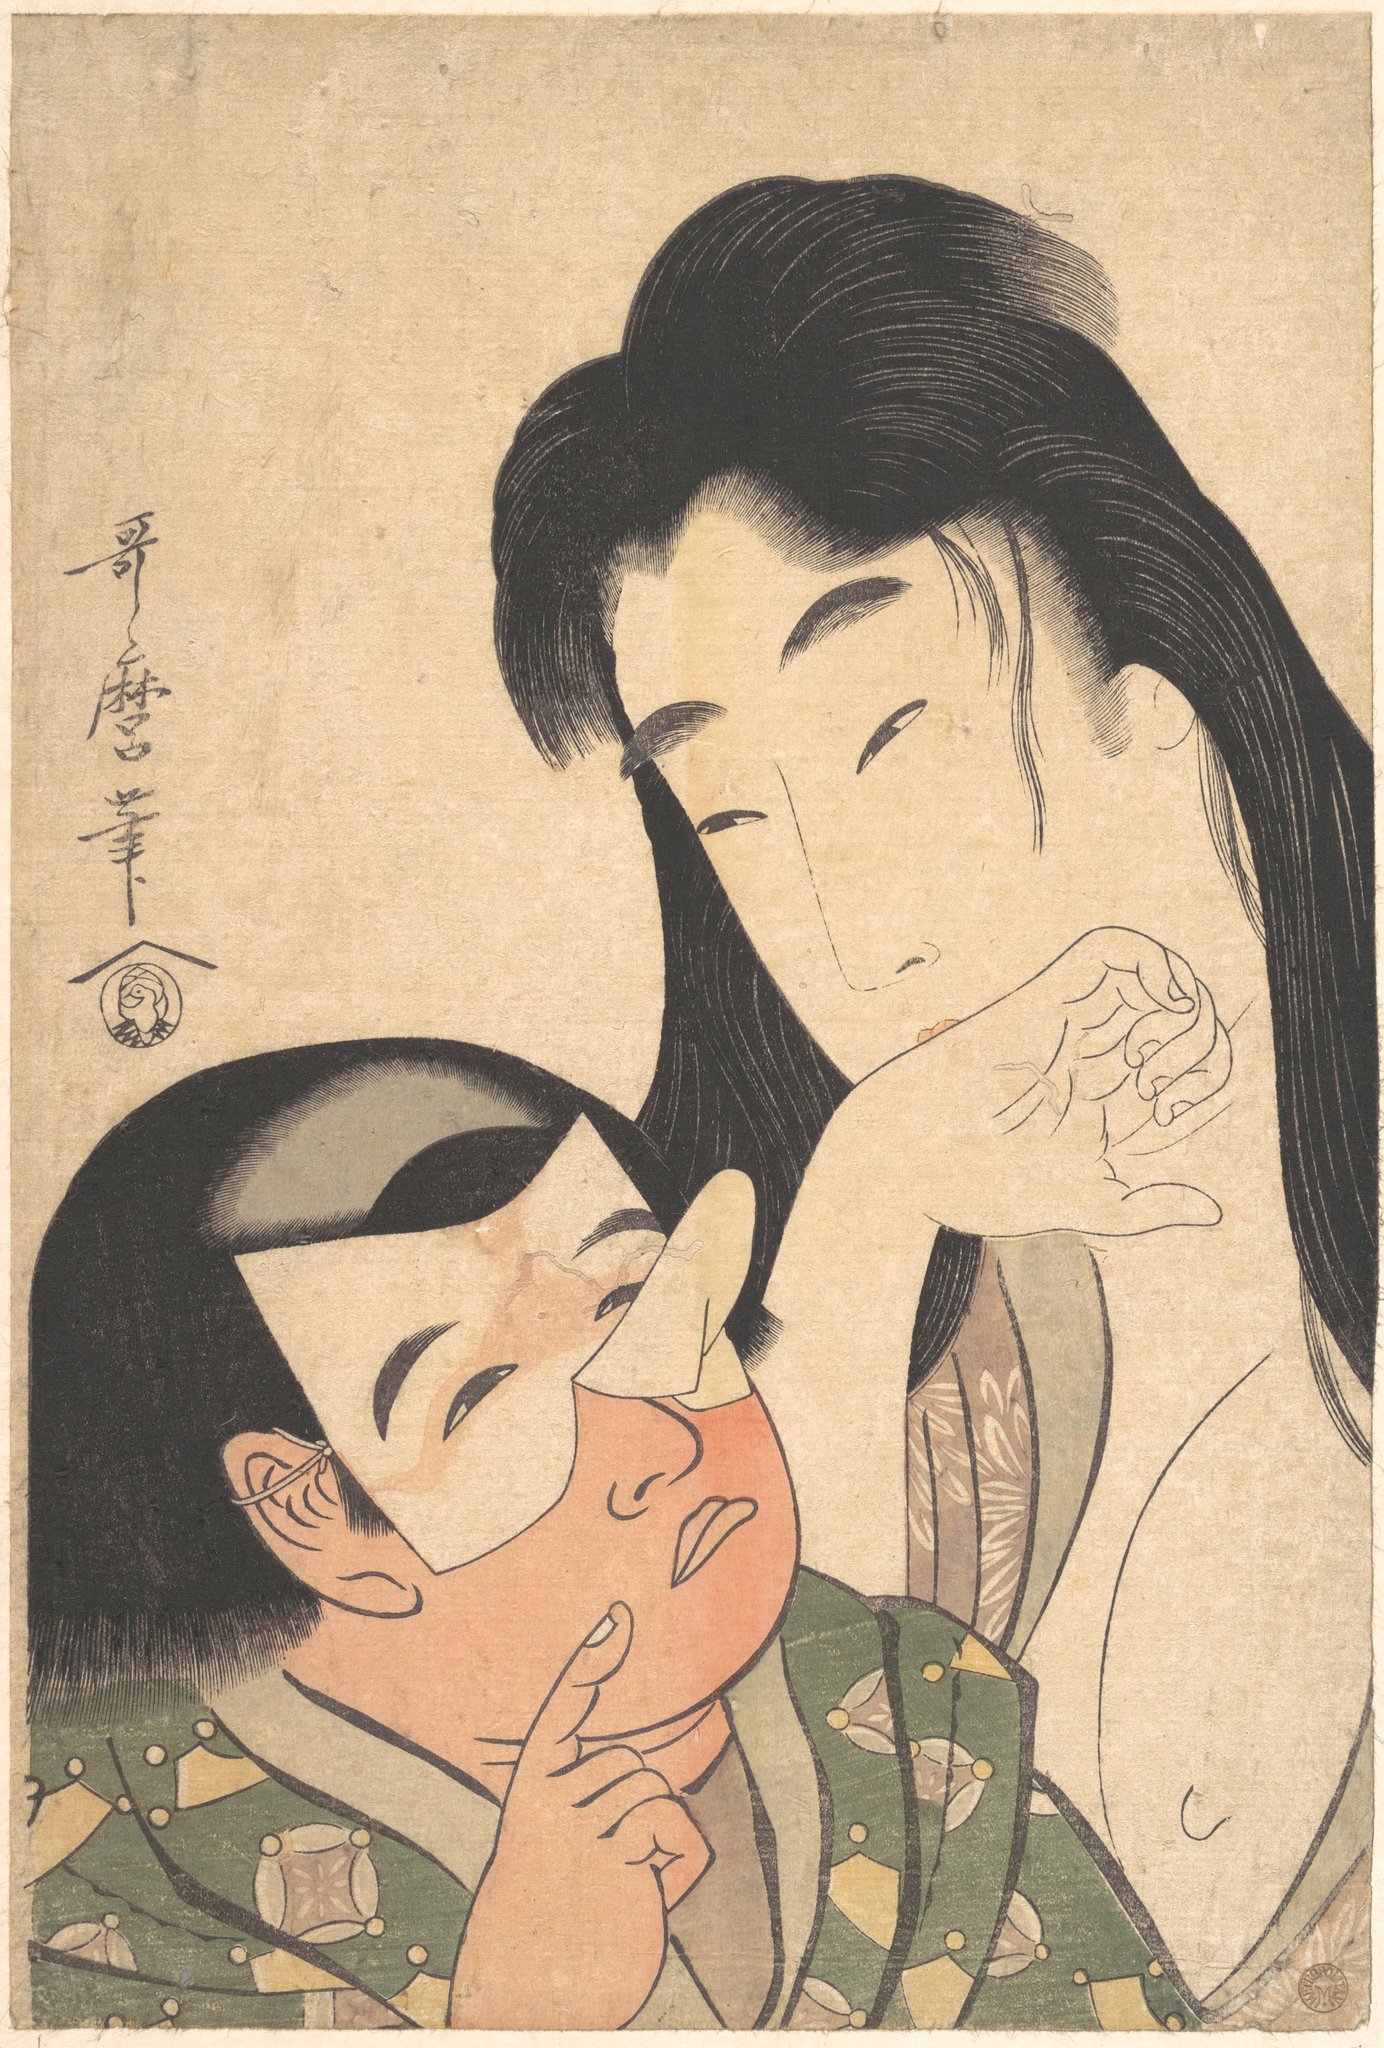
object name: print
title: Yamauba and Kintarō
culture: japanese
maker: kitagawa utamaro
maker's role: artist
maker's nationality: japanese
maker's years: 1754-1806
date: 1795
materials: ink, paper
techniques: nishiki e, woodblock print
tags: boys,women